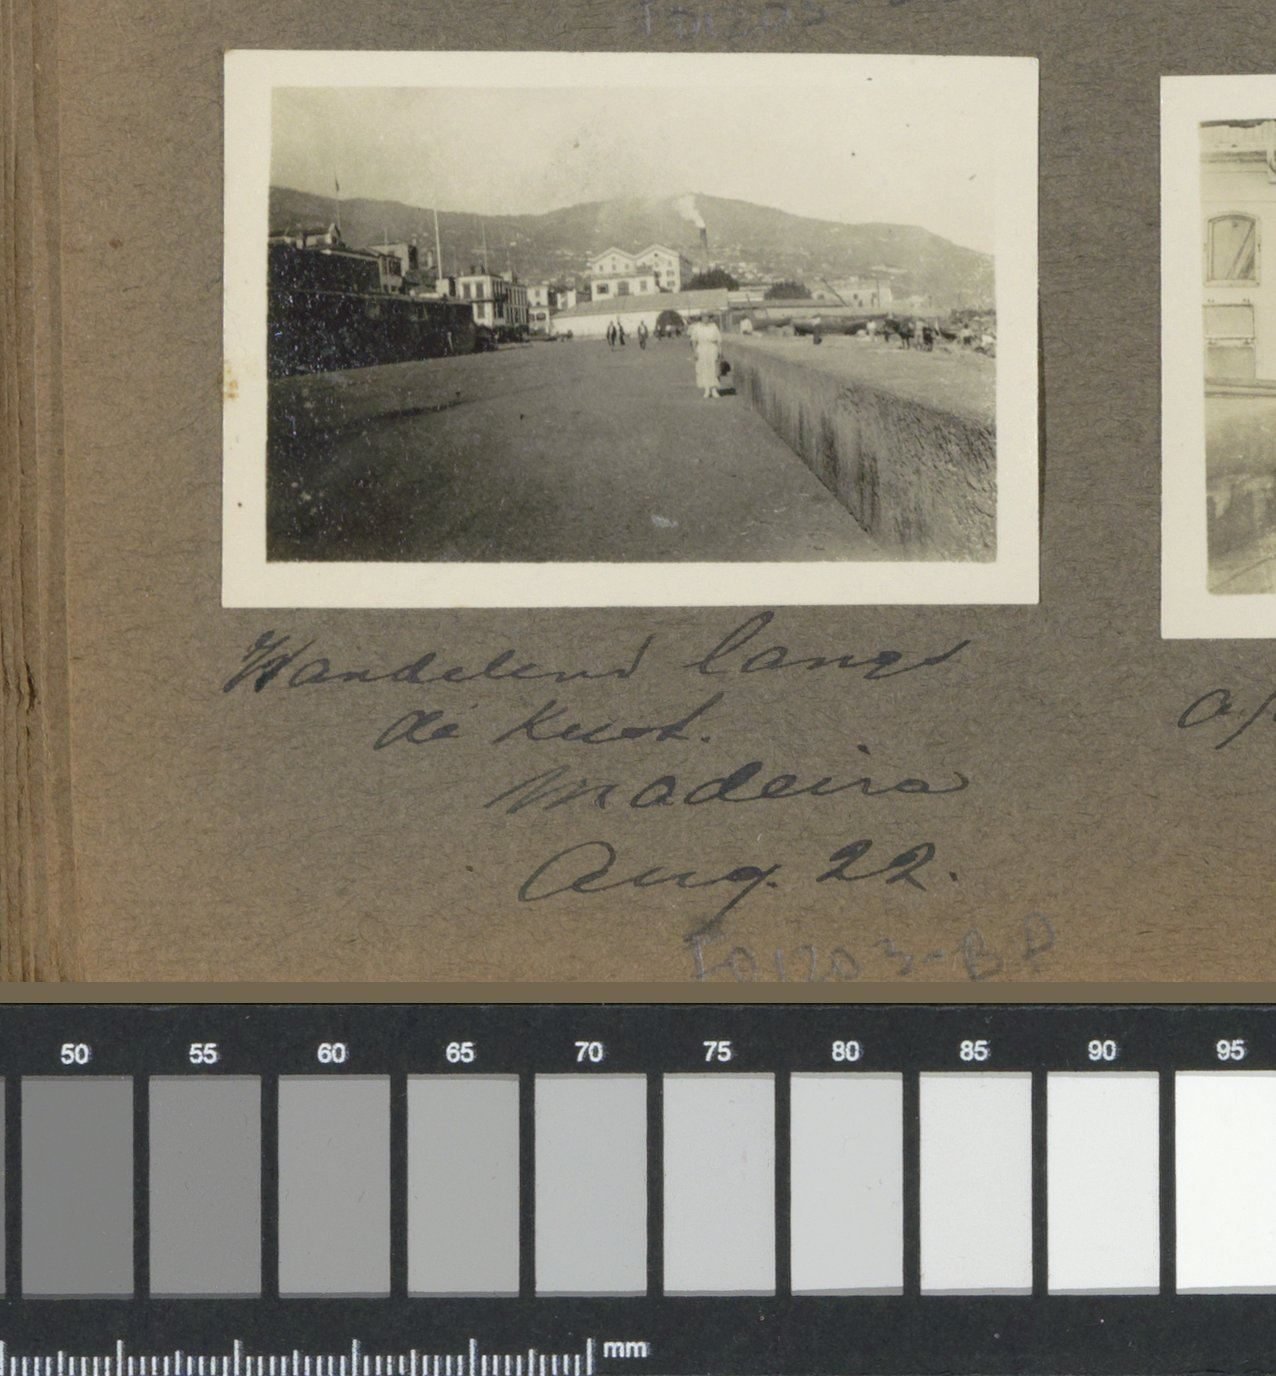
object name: photograph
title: Vrouw wandelend langs de kust op Madeira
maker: Anonymous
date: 1908-1922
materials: photographic support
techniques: gelatin silver print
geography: madeira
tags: quay (+ city(-scape) with figures, staffage)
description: Onderdeel van fotoalbum van een onbekende Nederlandse familie met opnames van Suriname, Europa en Nederlands-Indië.